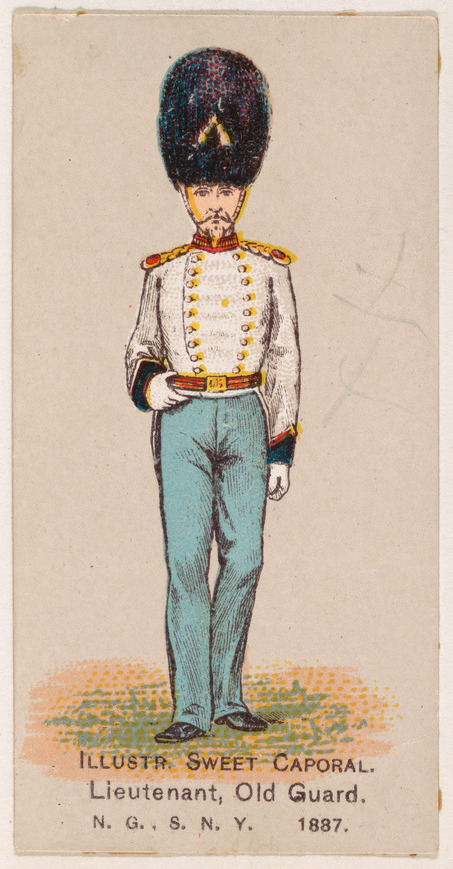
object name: print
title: Lieutenant, Old Guard, National Guard of the State of New York, 1887, from the Military Series (N224) issued by Kinney Tobacco Company to promote Sweet Caporal Cigarettes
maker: kinney brothers tobacco company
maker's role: publisher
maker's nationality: american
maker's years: 1869-2011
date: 1888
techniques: color lithograph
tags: military,men